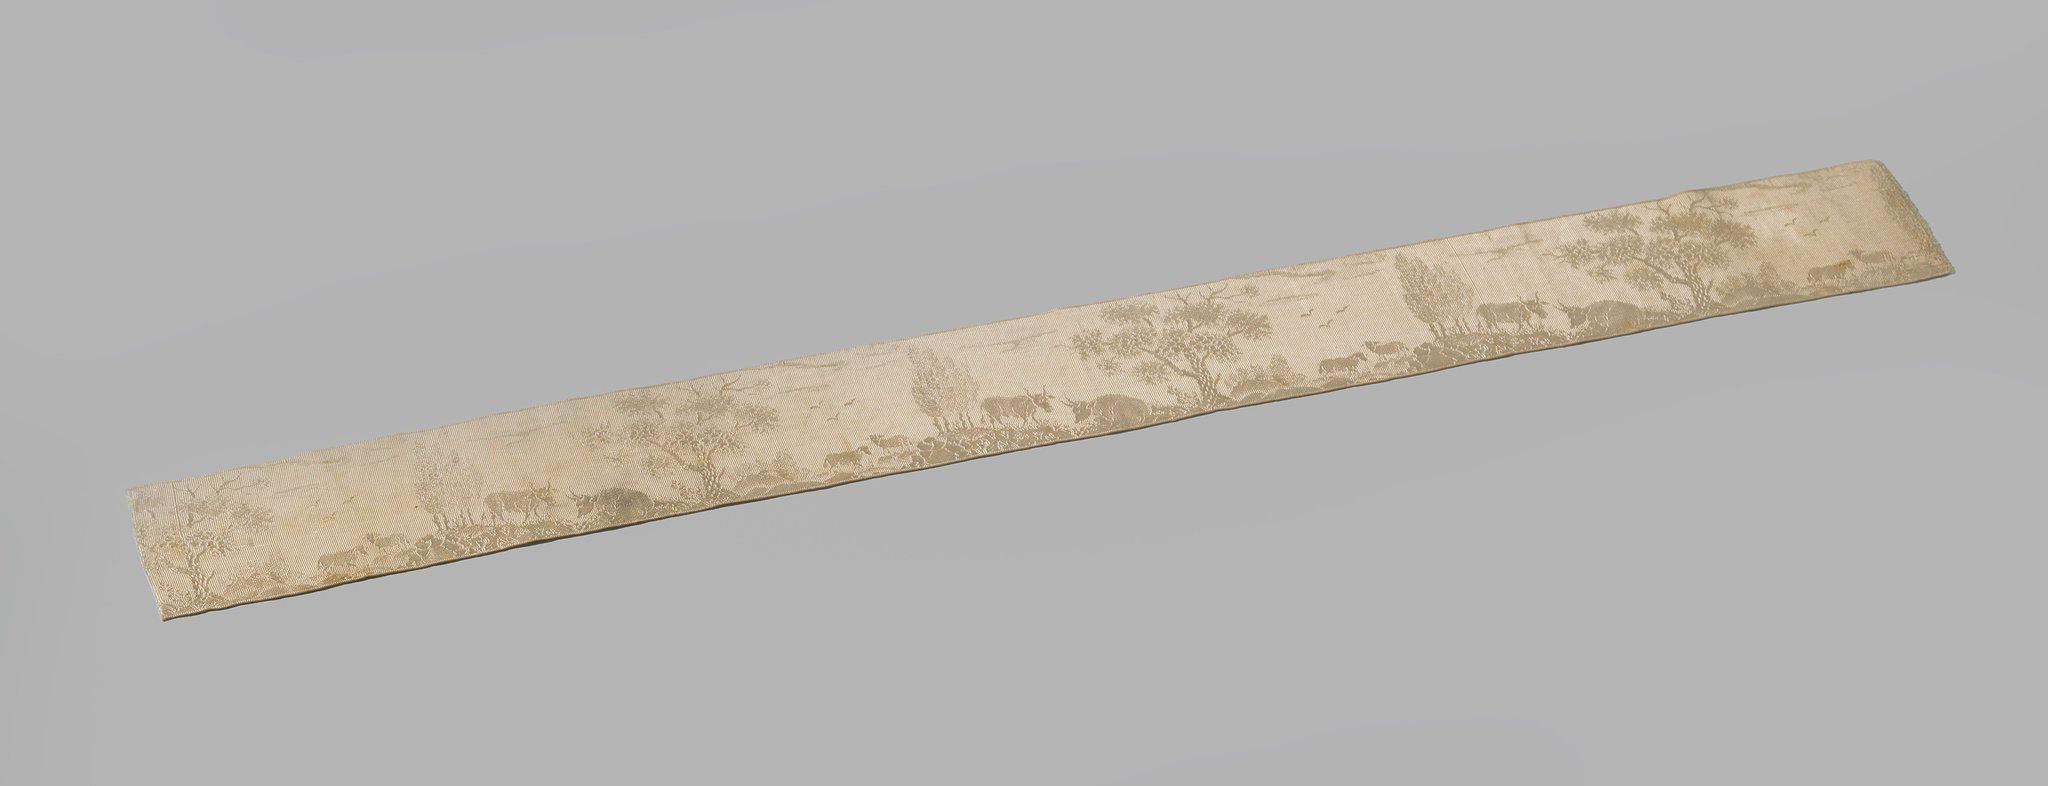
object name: ribbon material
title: Ceintuurlint van crème zijde in ripsbinding versierd met brocheerwerk in de vorm van koeien en schapen in een landschap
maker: Anonymous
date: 1800-1900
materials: silk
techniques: brocade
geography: france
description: Ceintuurlint van crème zijde in ripsbinding versierd met brocheerwerk in de vorm van koeien en schapen in een landschap.